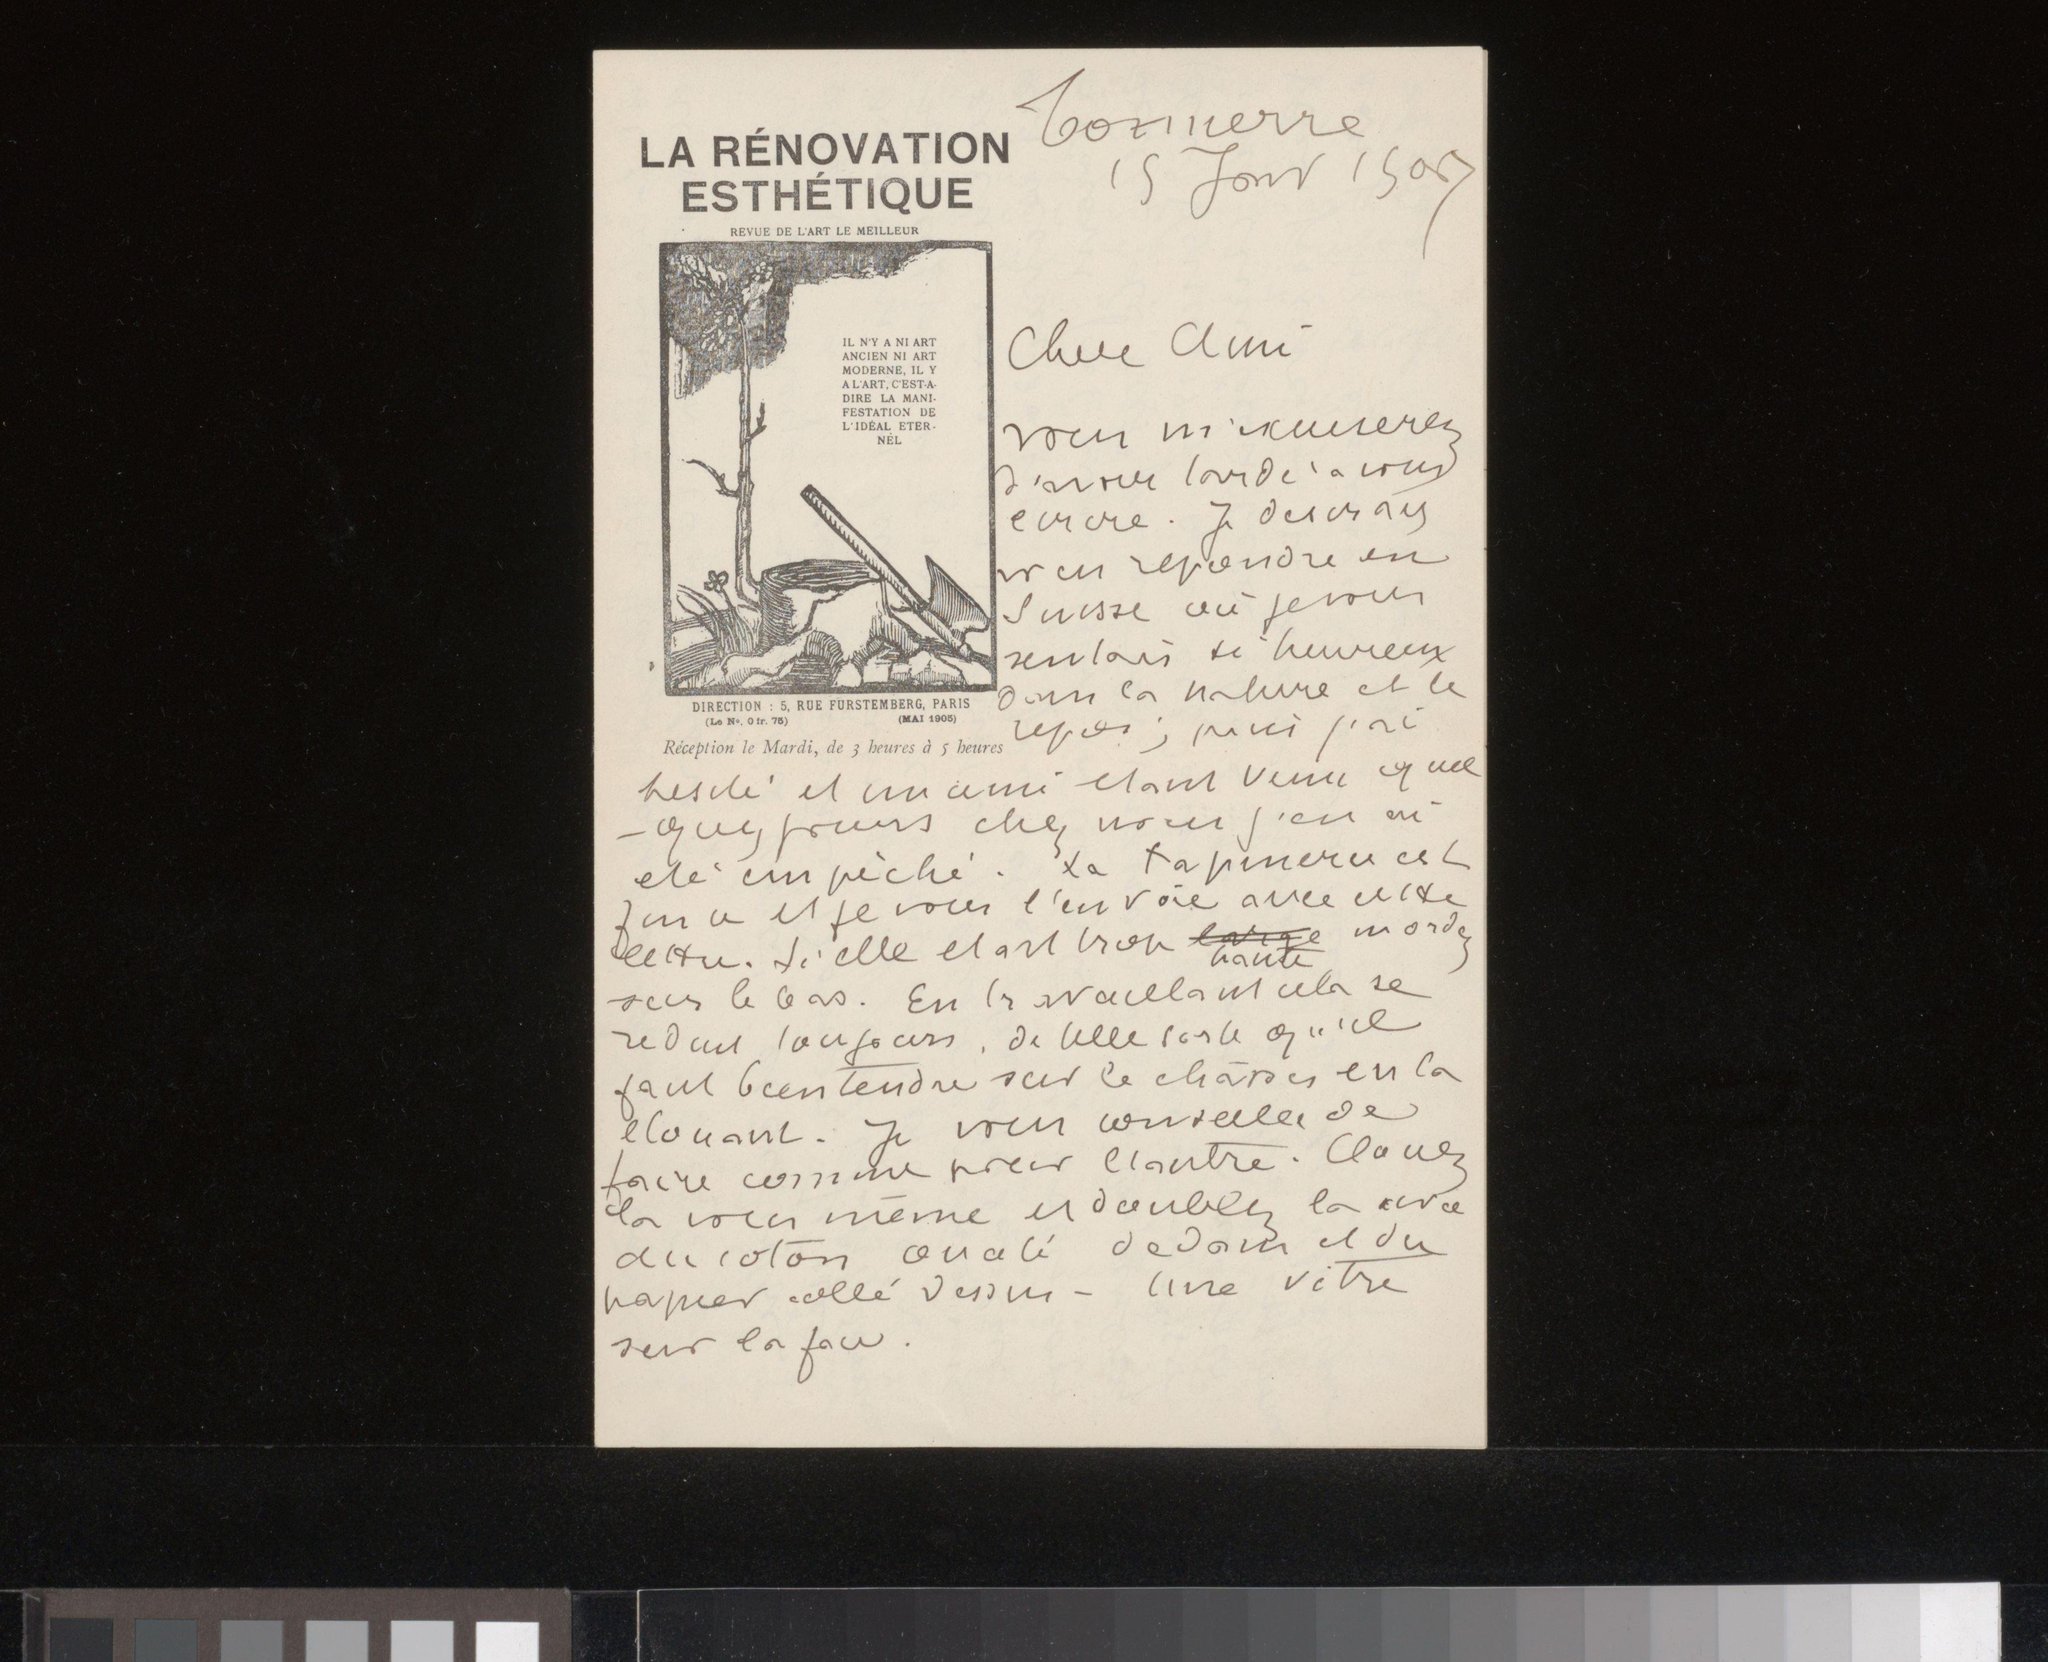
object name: letter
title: Brief aan Andries Bonger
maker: émile bernard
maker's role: print maker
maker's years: 1868-1941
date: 1907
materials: ink, paper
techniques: pen, printing, writing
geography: tonnerre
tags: painter, print maker, vincent van gogh, amsterdam, andries bonger, applied arts, arts and crafts; industrial design, painting (including book-illumination, miniature-painting), switzerland